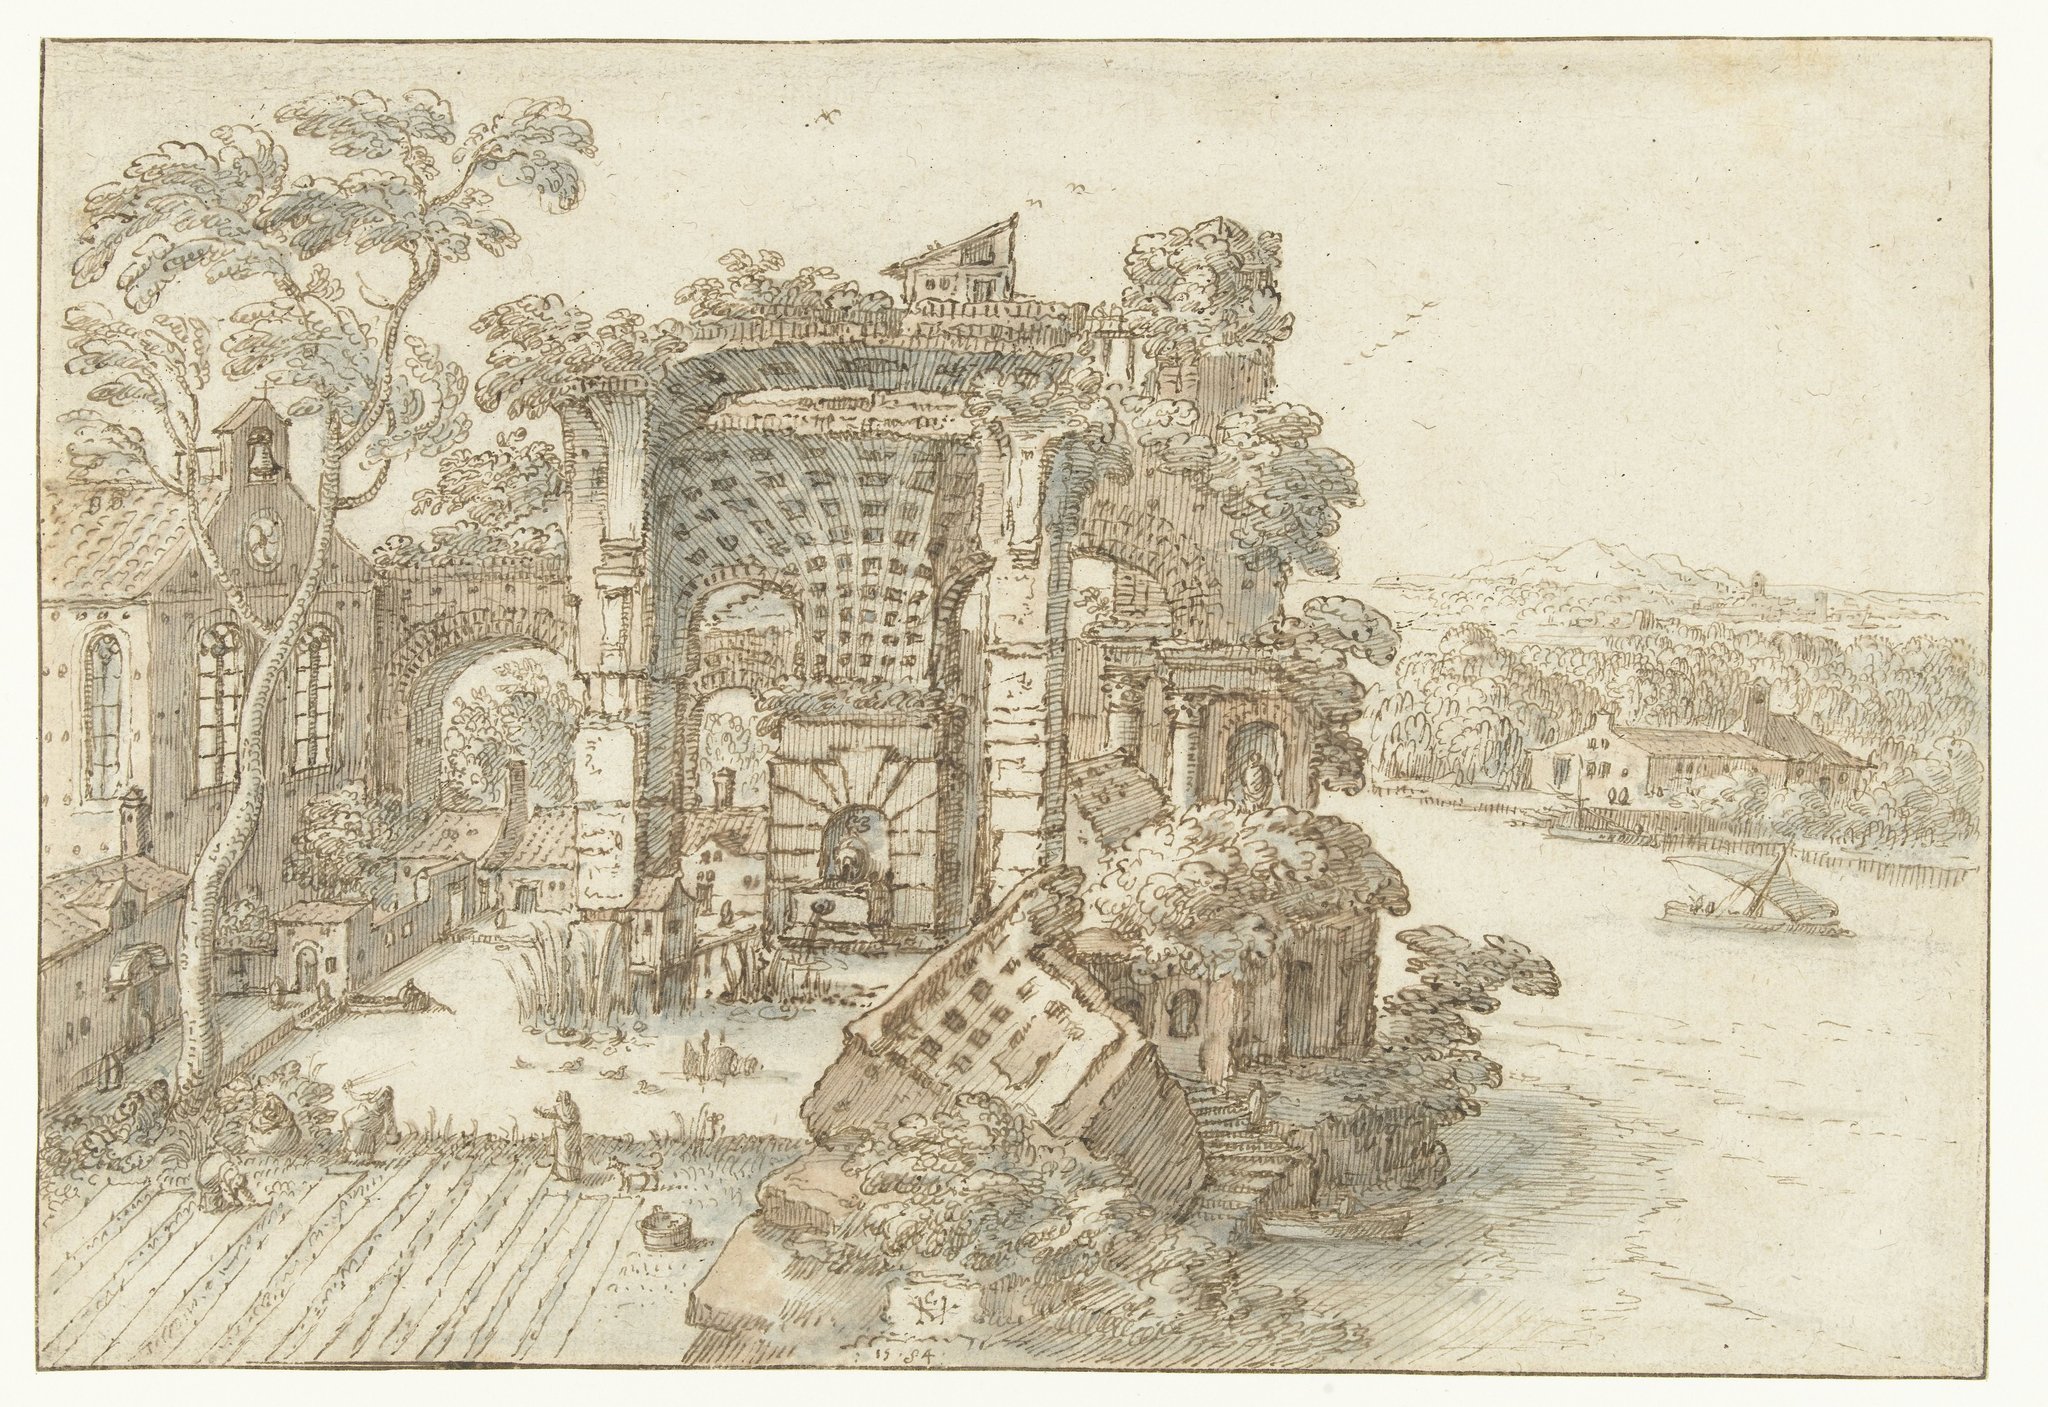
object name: drawing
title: Regionum, Rurium, Fundorumque (...)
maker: hendrick van cleve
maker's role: draughtsman, print maker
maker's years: 1525-1589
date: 1584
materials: paper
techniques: brush, pen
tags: landscape with ruins, river (+ landscape with figures, staffage)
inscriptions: date